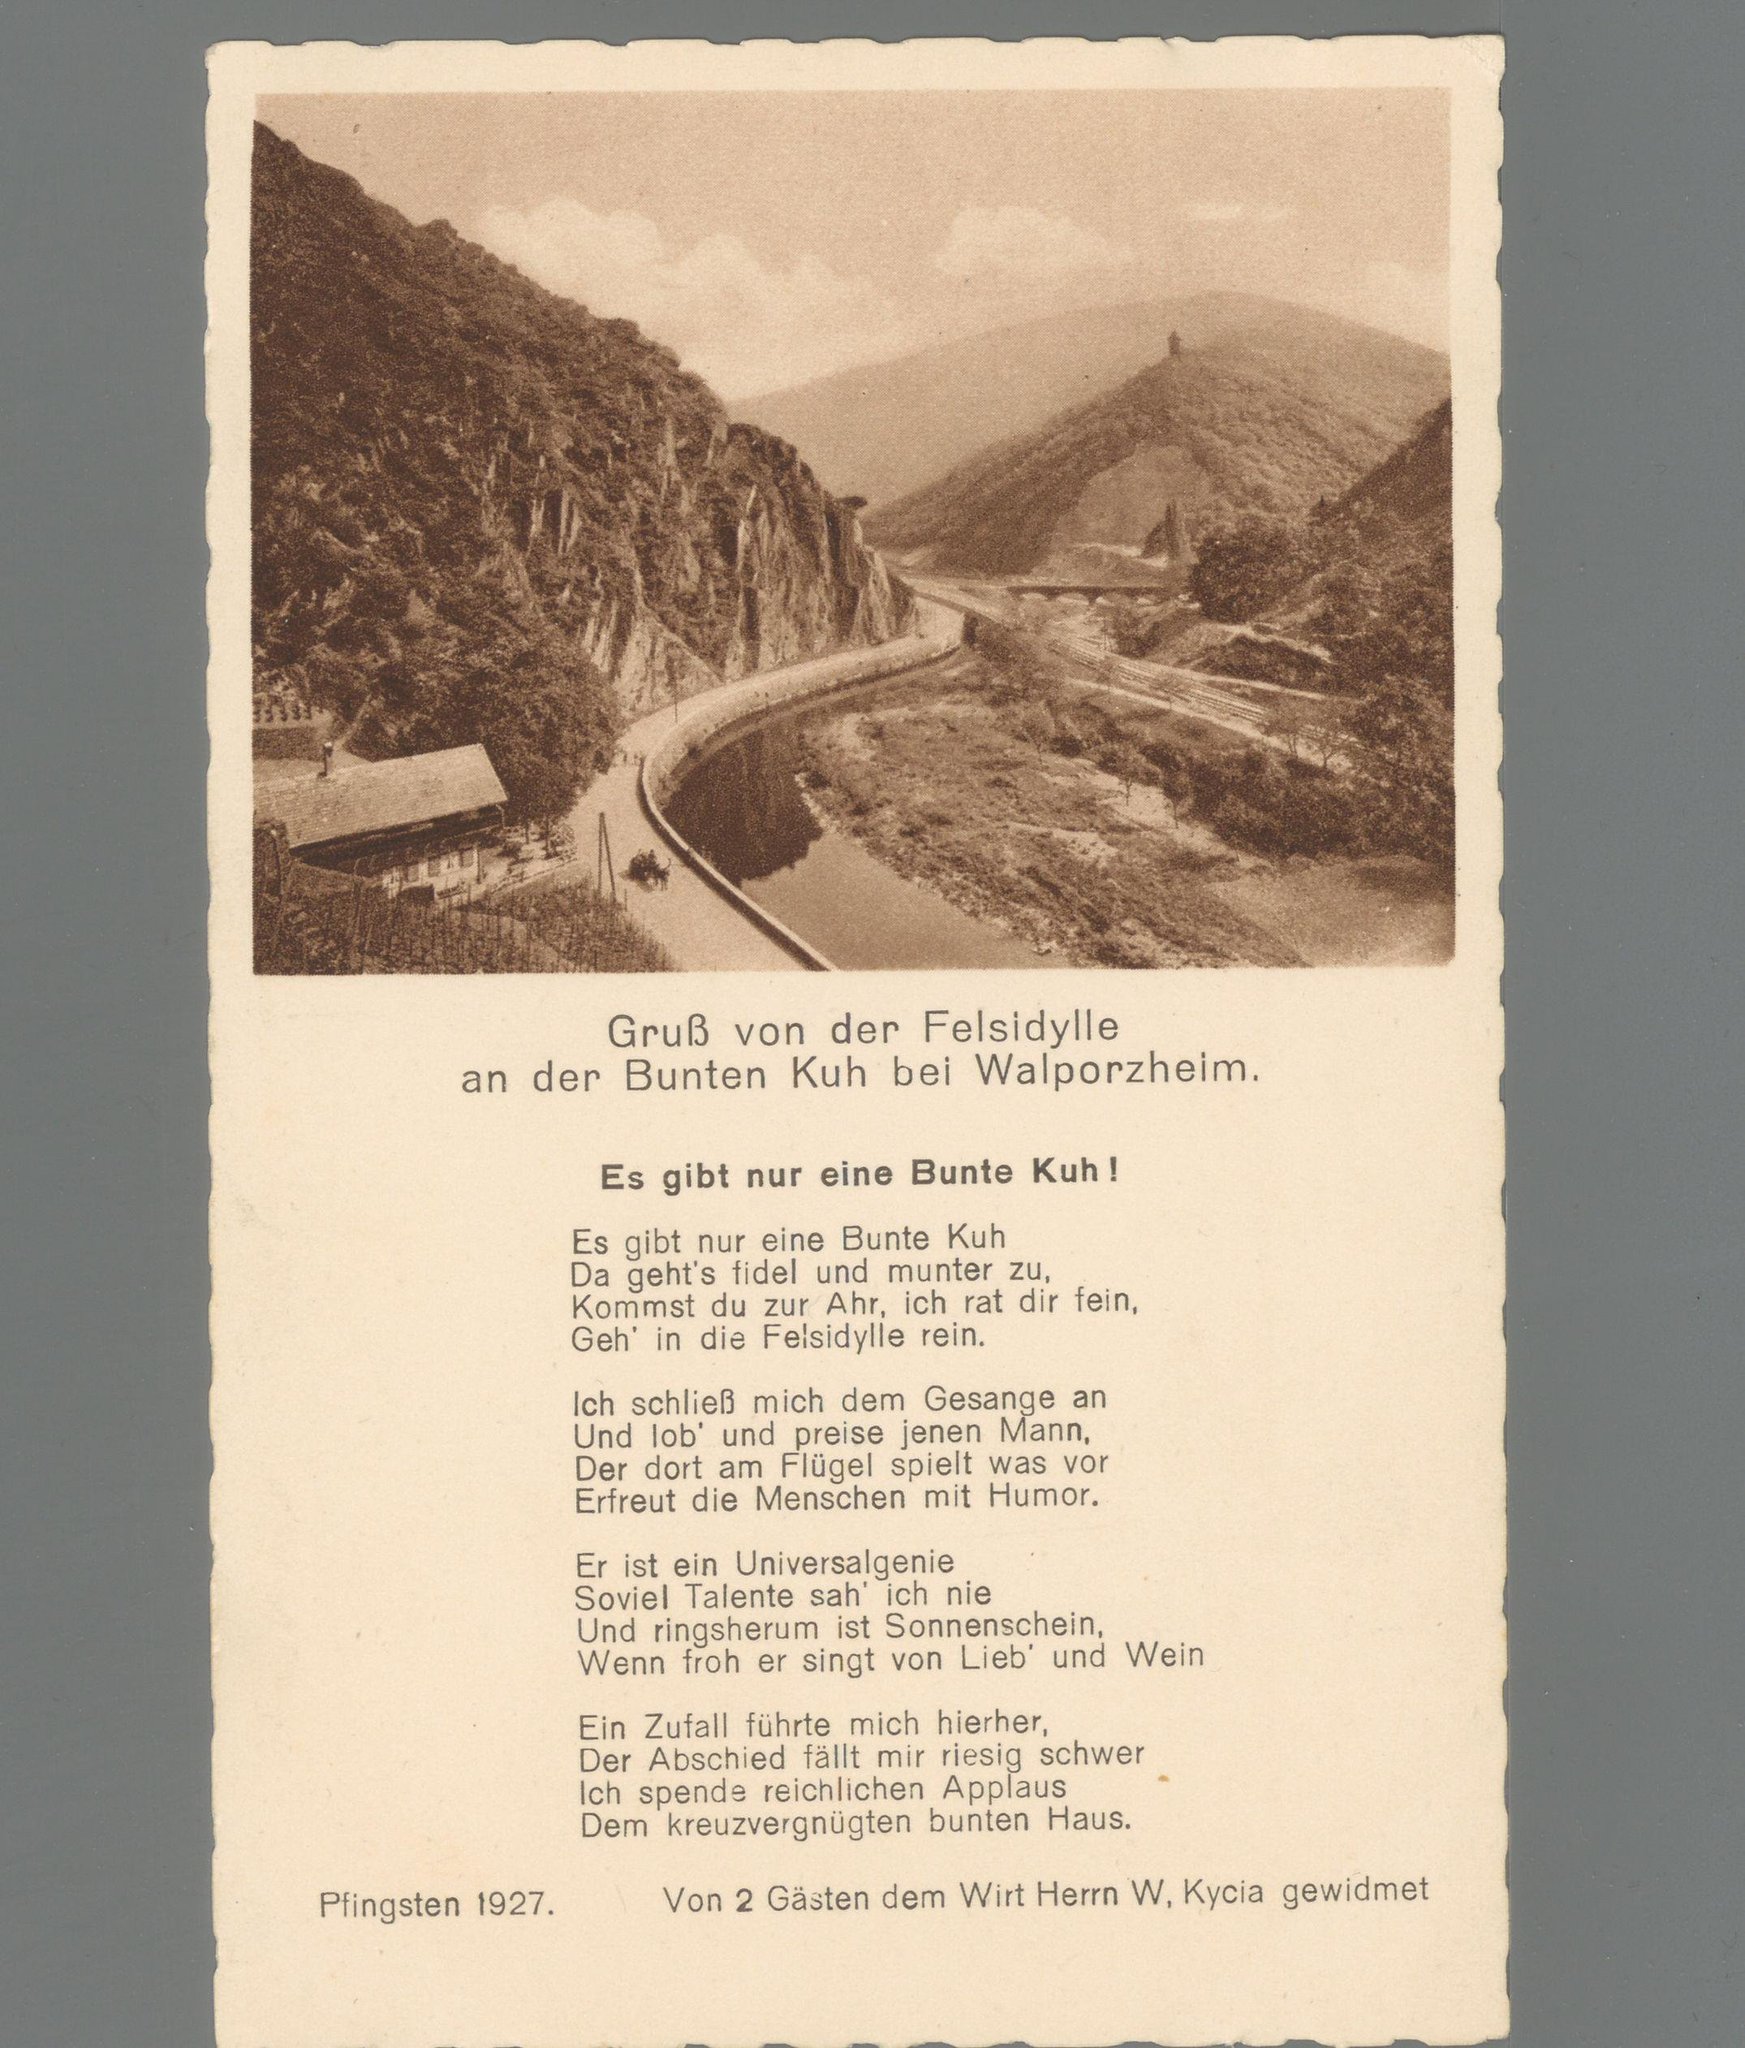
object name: photomechanical print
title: Gruβ von der Felsidylle an der Bunten Kuh bei Walporzheim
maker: Anonymous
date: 1927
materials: cardboard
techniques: rotogravure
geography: bad neuenahr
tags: river, bridge, mountains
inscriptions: date